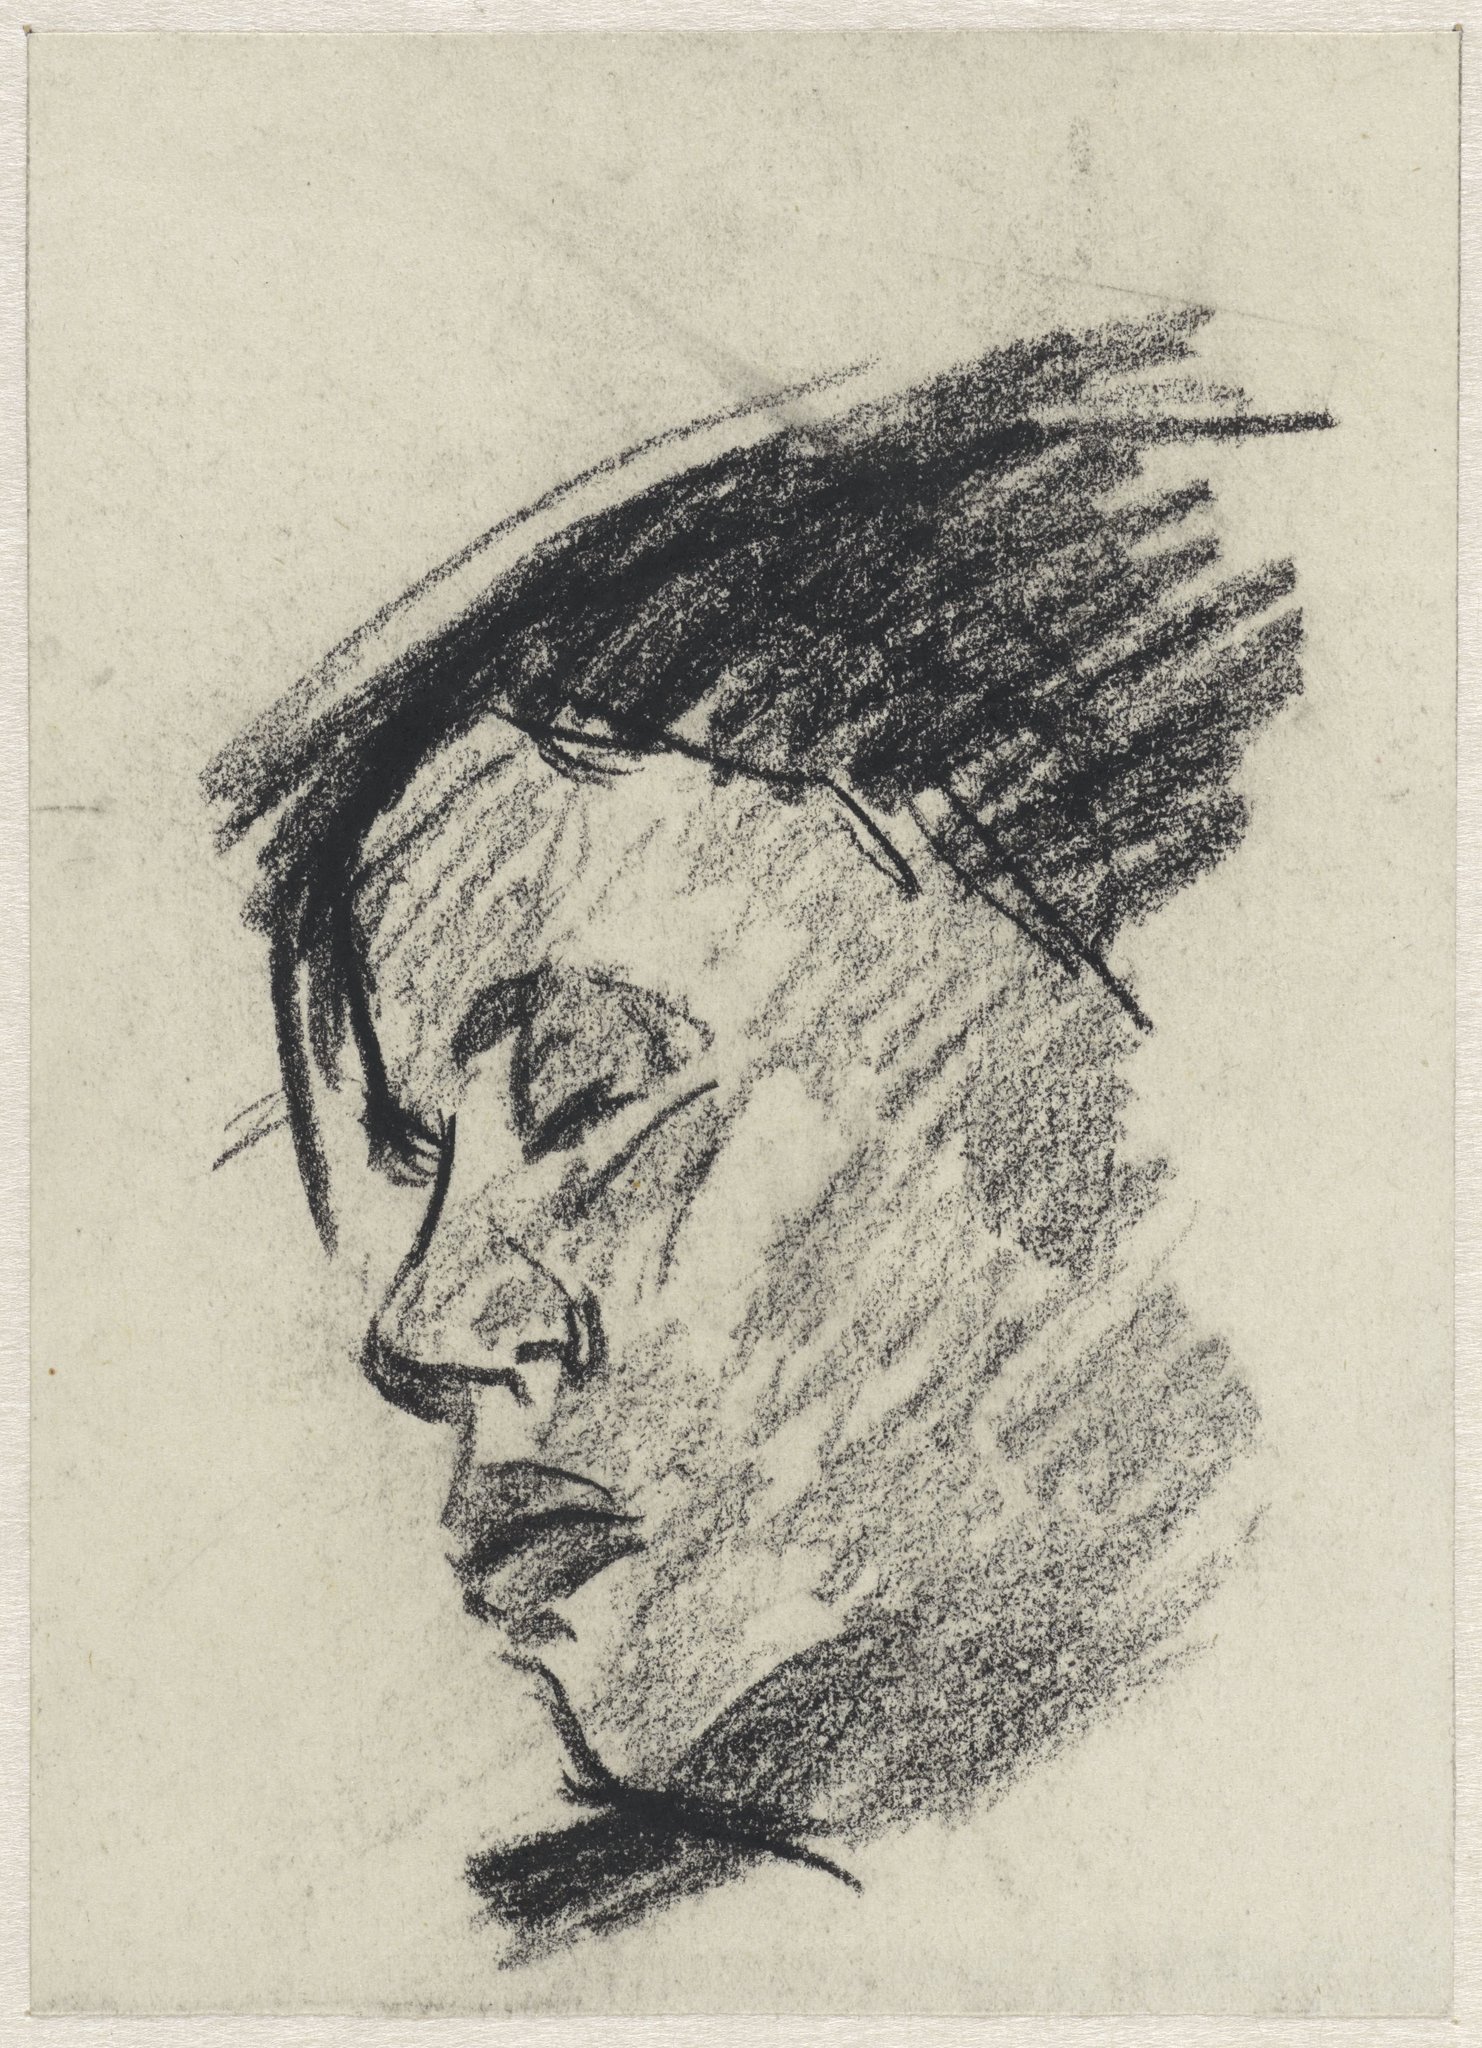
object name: drawing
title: Hoofd van een slapende vrouw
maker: suze robertson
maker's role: draughtsman, painter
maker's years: 1855-1922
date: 1865-1922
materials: chalk, paper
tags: head (human), female sex; woman, sleeping; unconsciousness